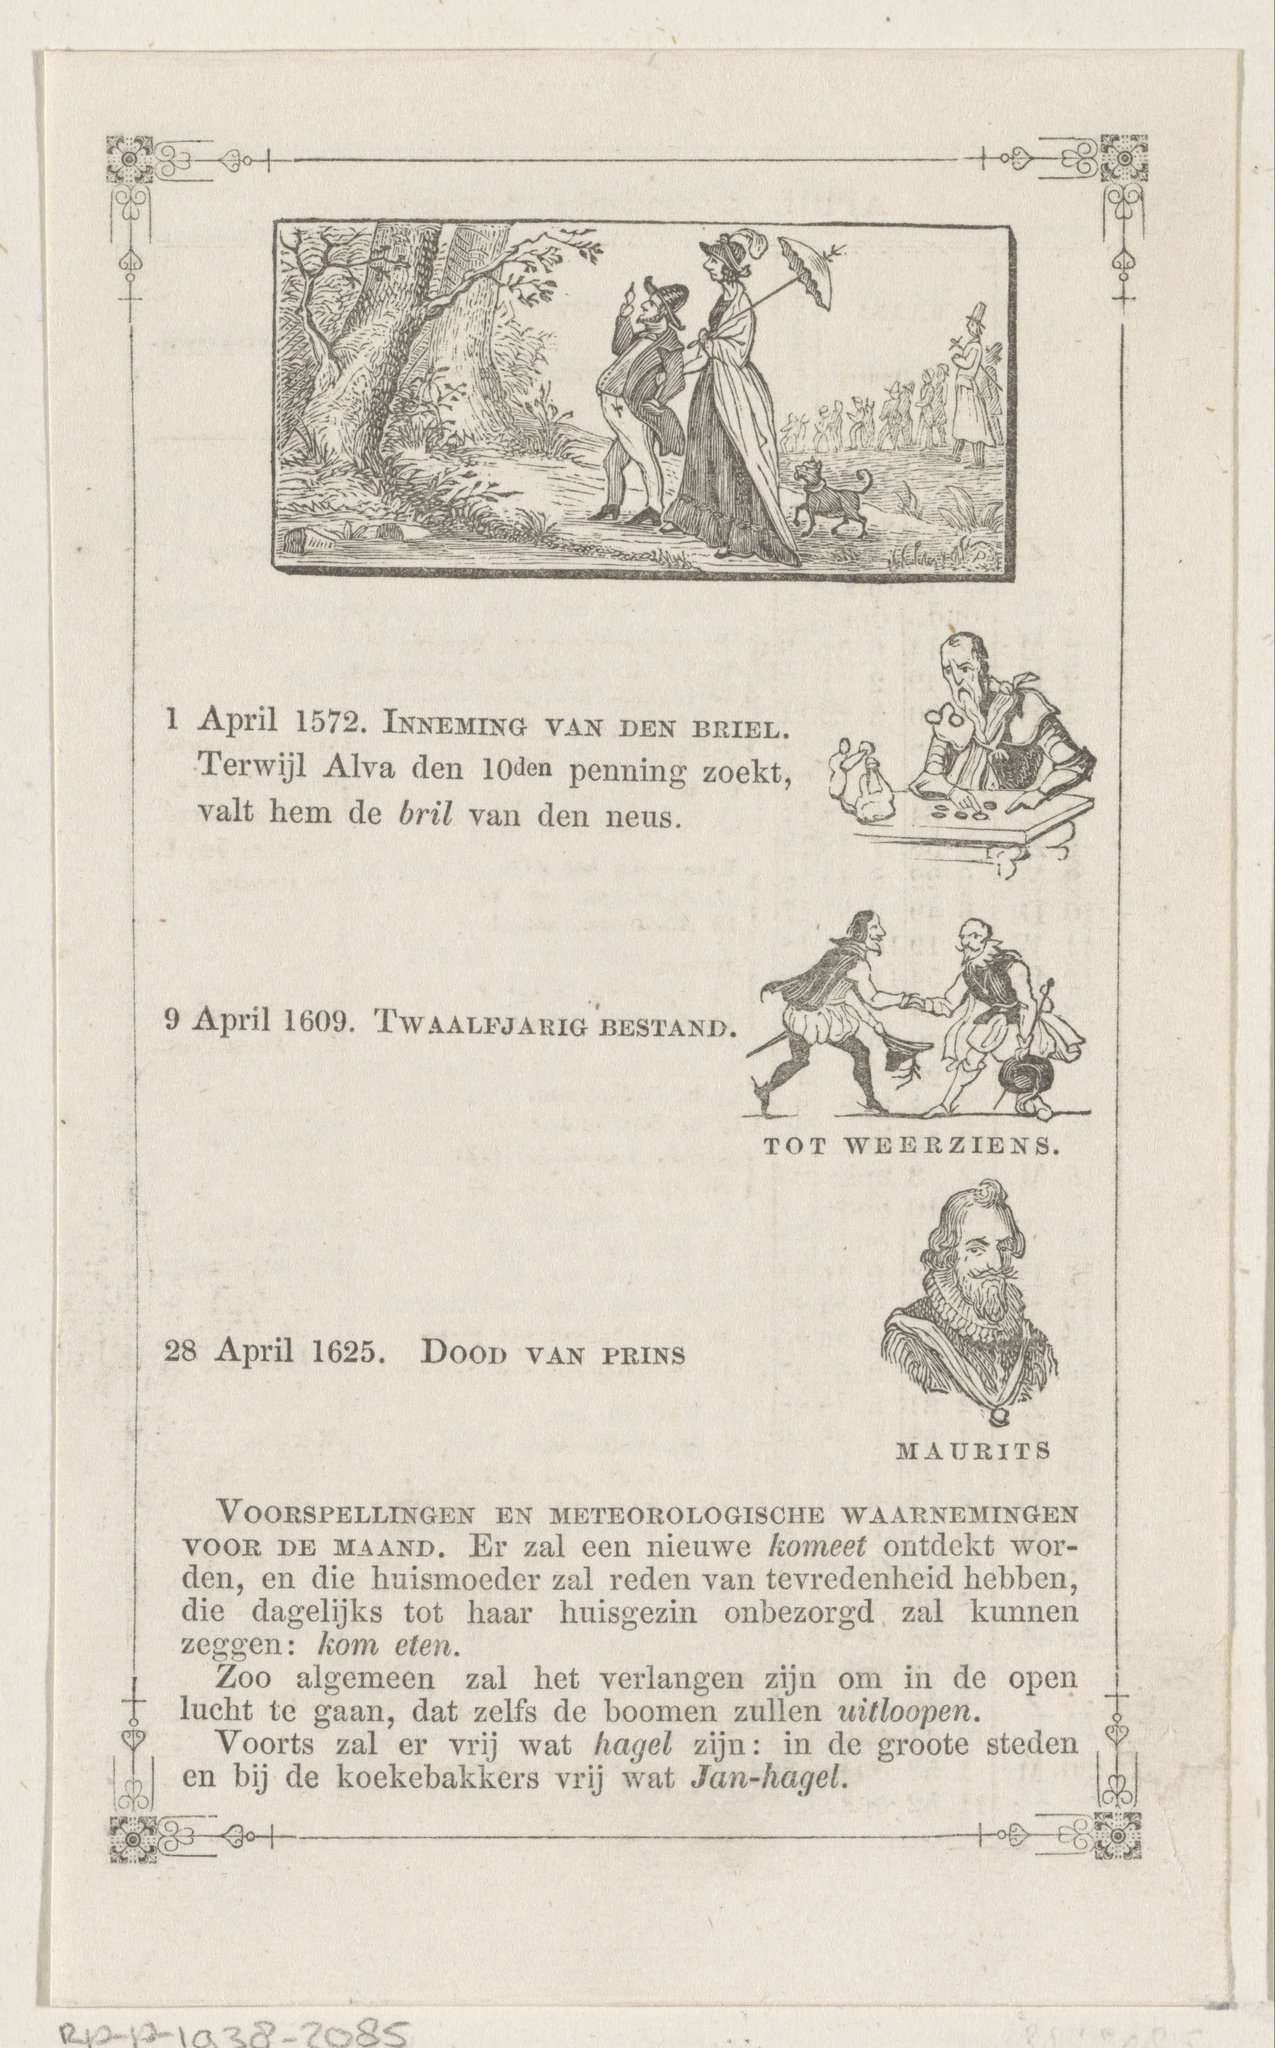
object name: book illustration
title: April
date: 1849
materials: paper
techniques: letterpress printing, engraving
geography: amsterdam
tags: twaalfjarig bestand, dood van maurits, inname van den briel (1572)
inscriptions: collector's mark: Lugt 2228, collector's mark: Lugt 2760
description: Midden boven een voorstelling van figuren kijkend naar uitlopende bomen. Daaronder een aantal voorstellingen van gebeurtenissen die plaatsvonden in de maand april, waaronder de inname van Den Briel in 1572, het Twaalfjarig Bestand in 1609 en de dood van Maurits in 1625. Midden onder voorspellingen en meteorologische waarnemeningen voor de maand april in 1849.